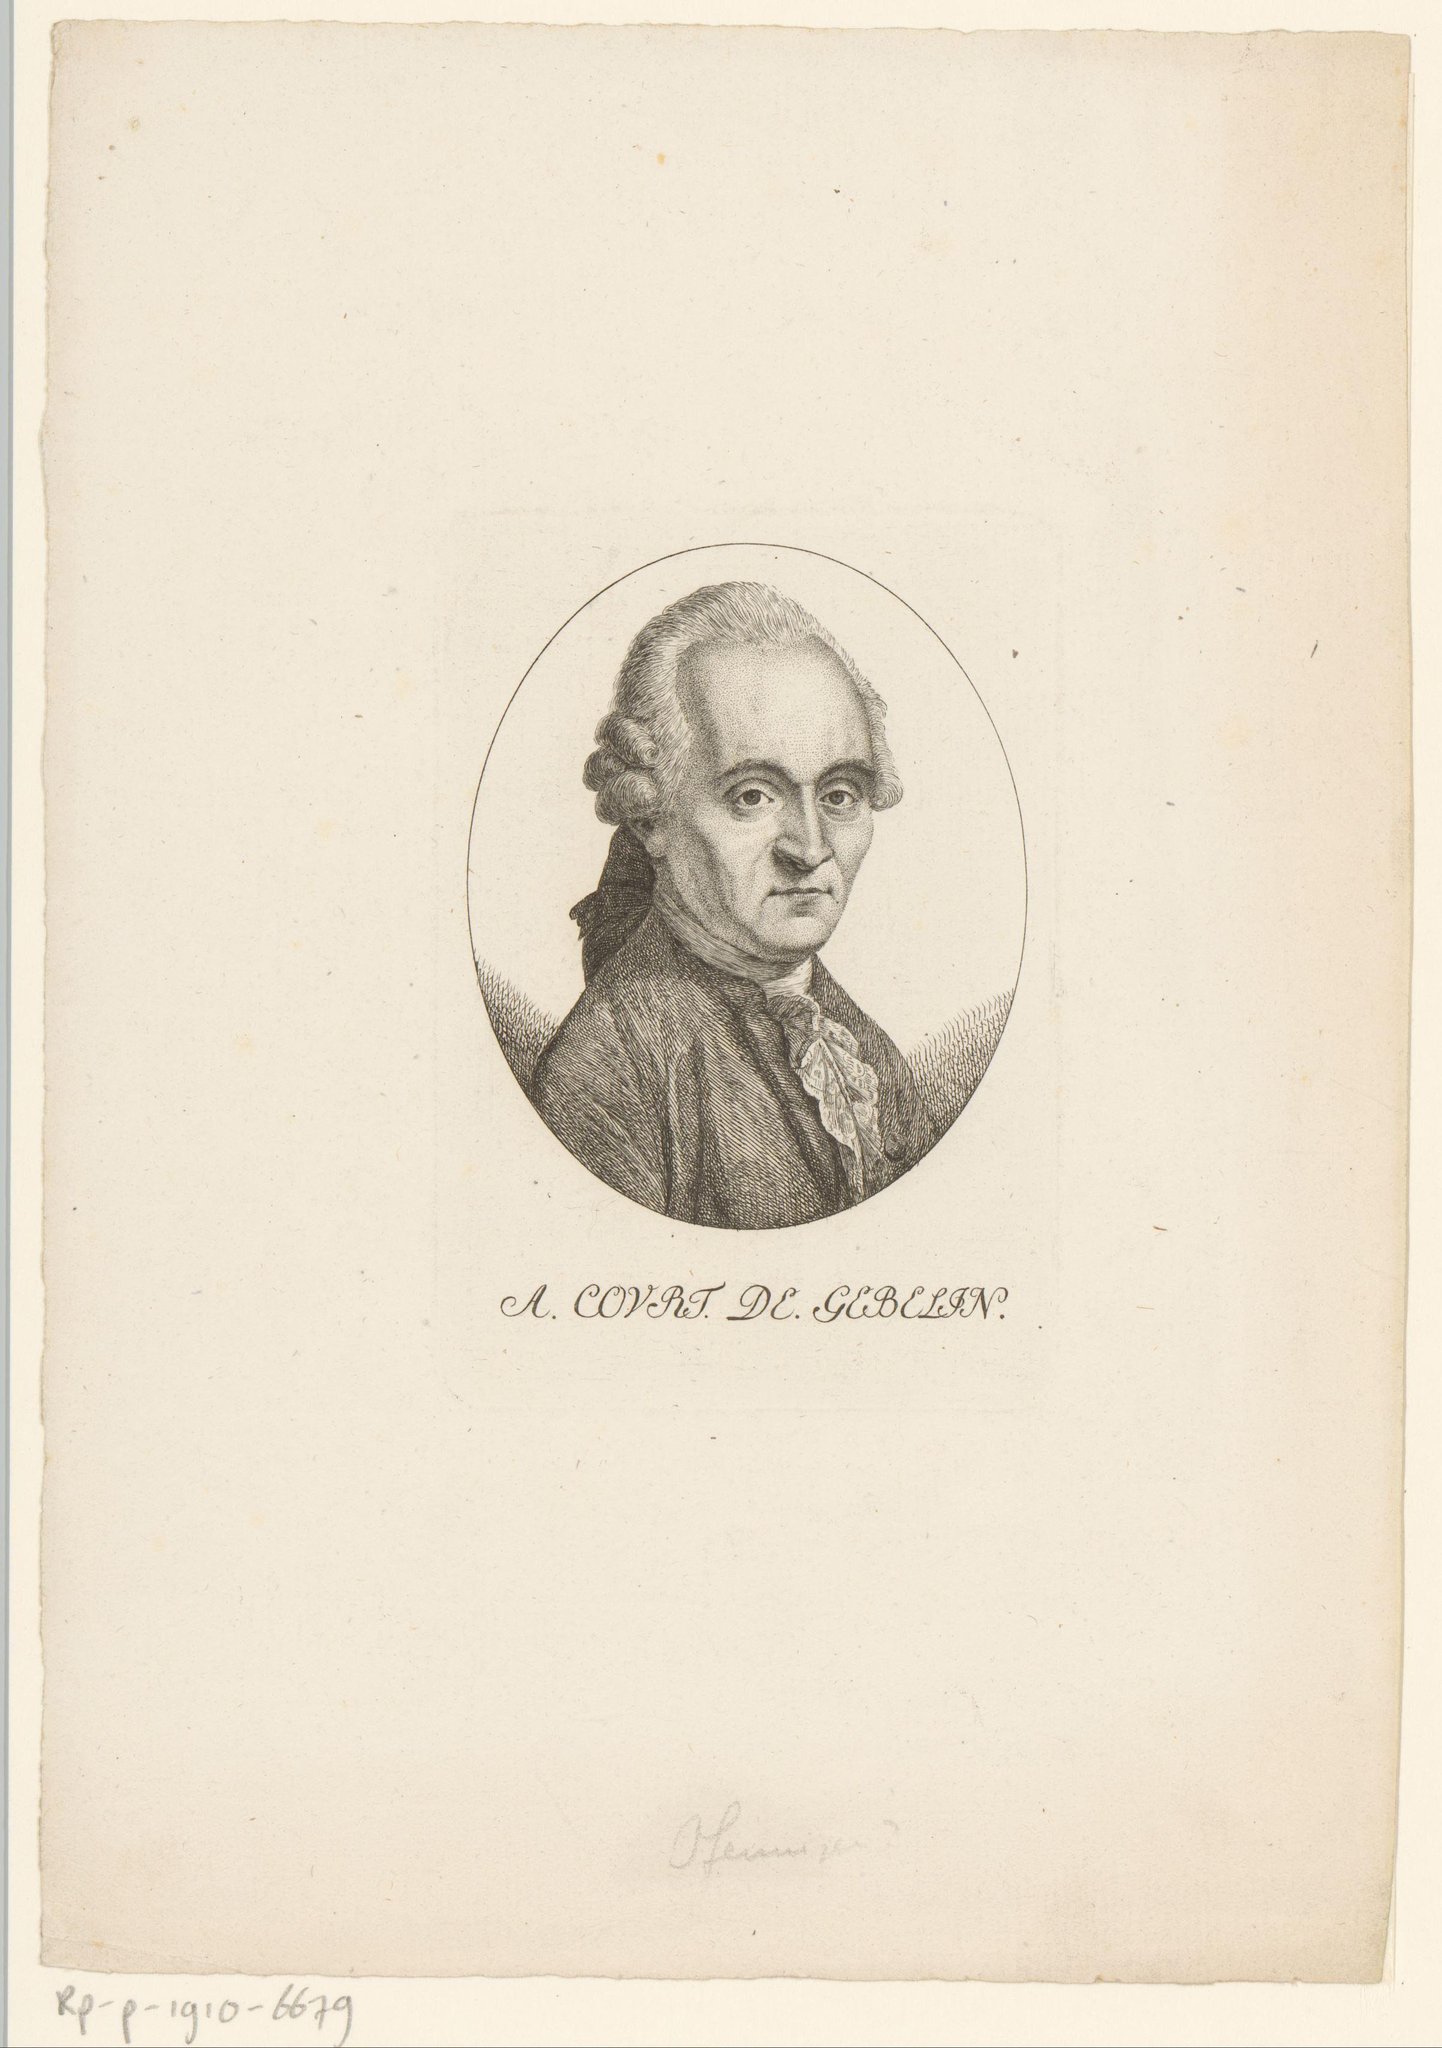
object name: print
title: Portret van Antoine Court de Gébelin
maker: heinrich pfenninger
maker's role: print maker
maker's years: 1749-1815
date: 1759-1815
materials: paper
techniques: etching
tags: paris, historical persons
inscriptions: name, collector's mark: Lugt 2228